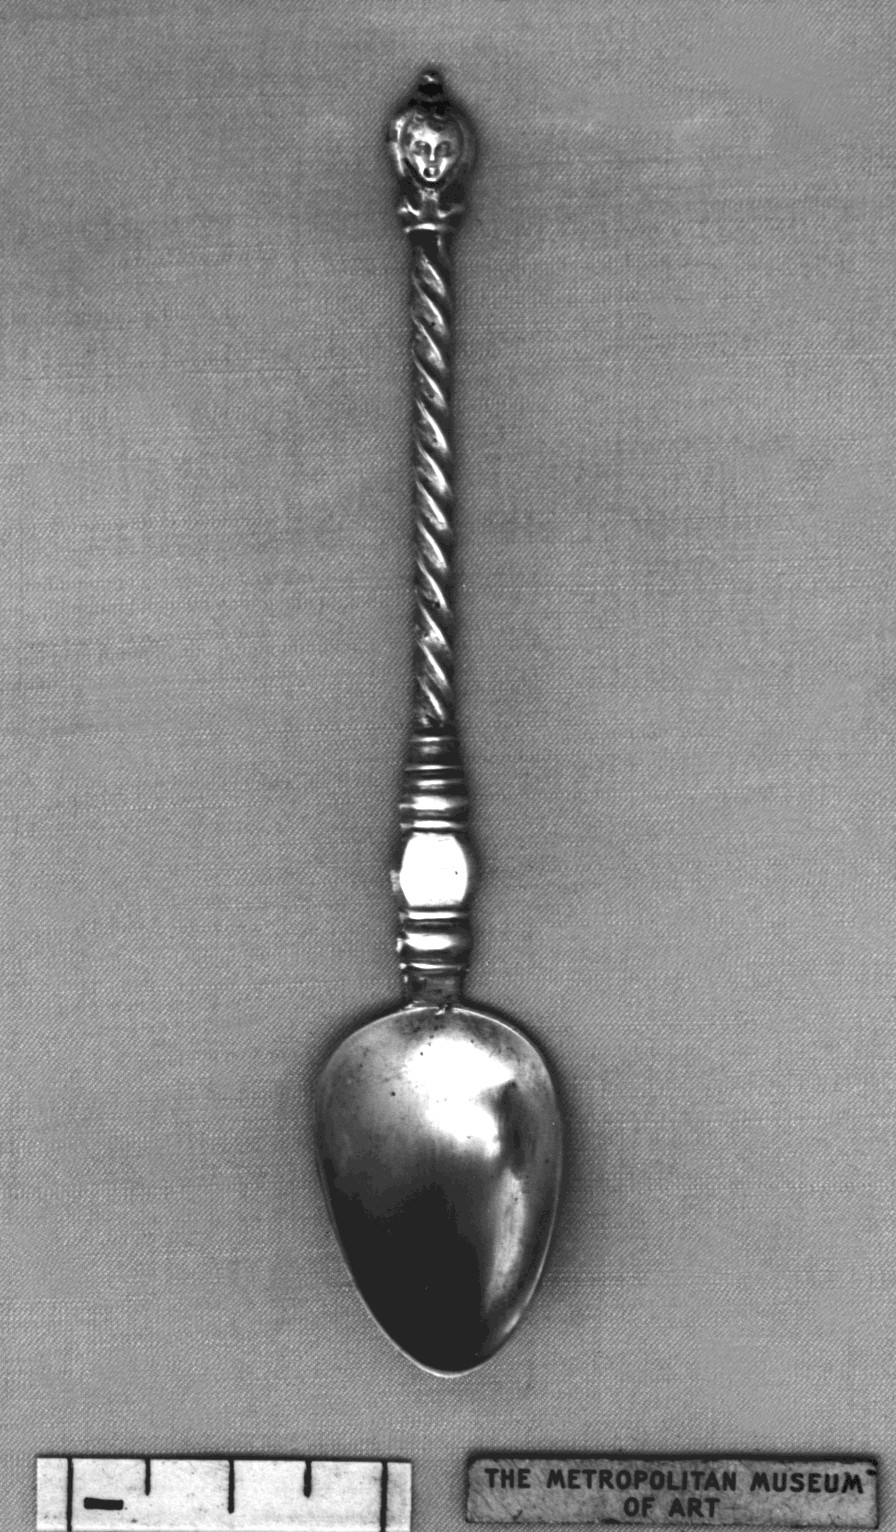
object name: coffee spoon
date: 1801-1833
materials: silver